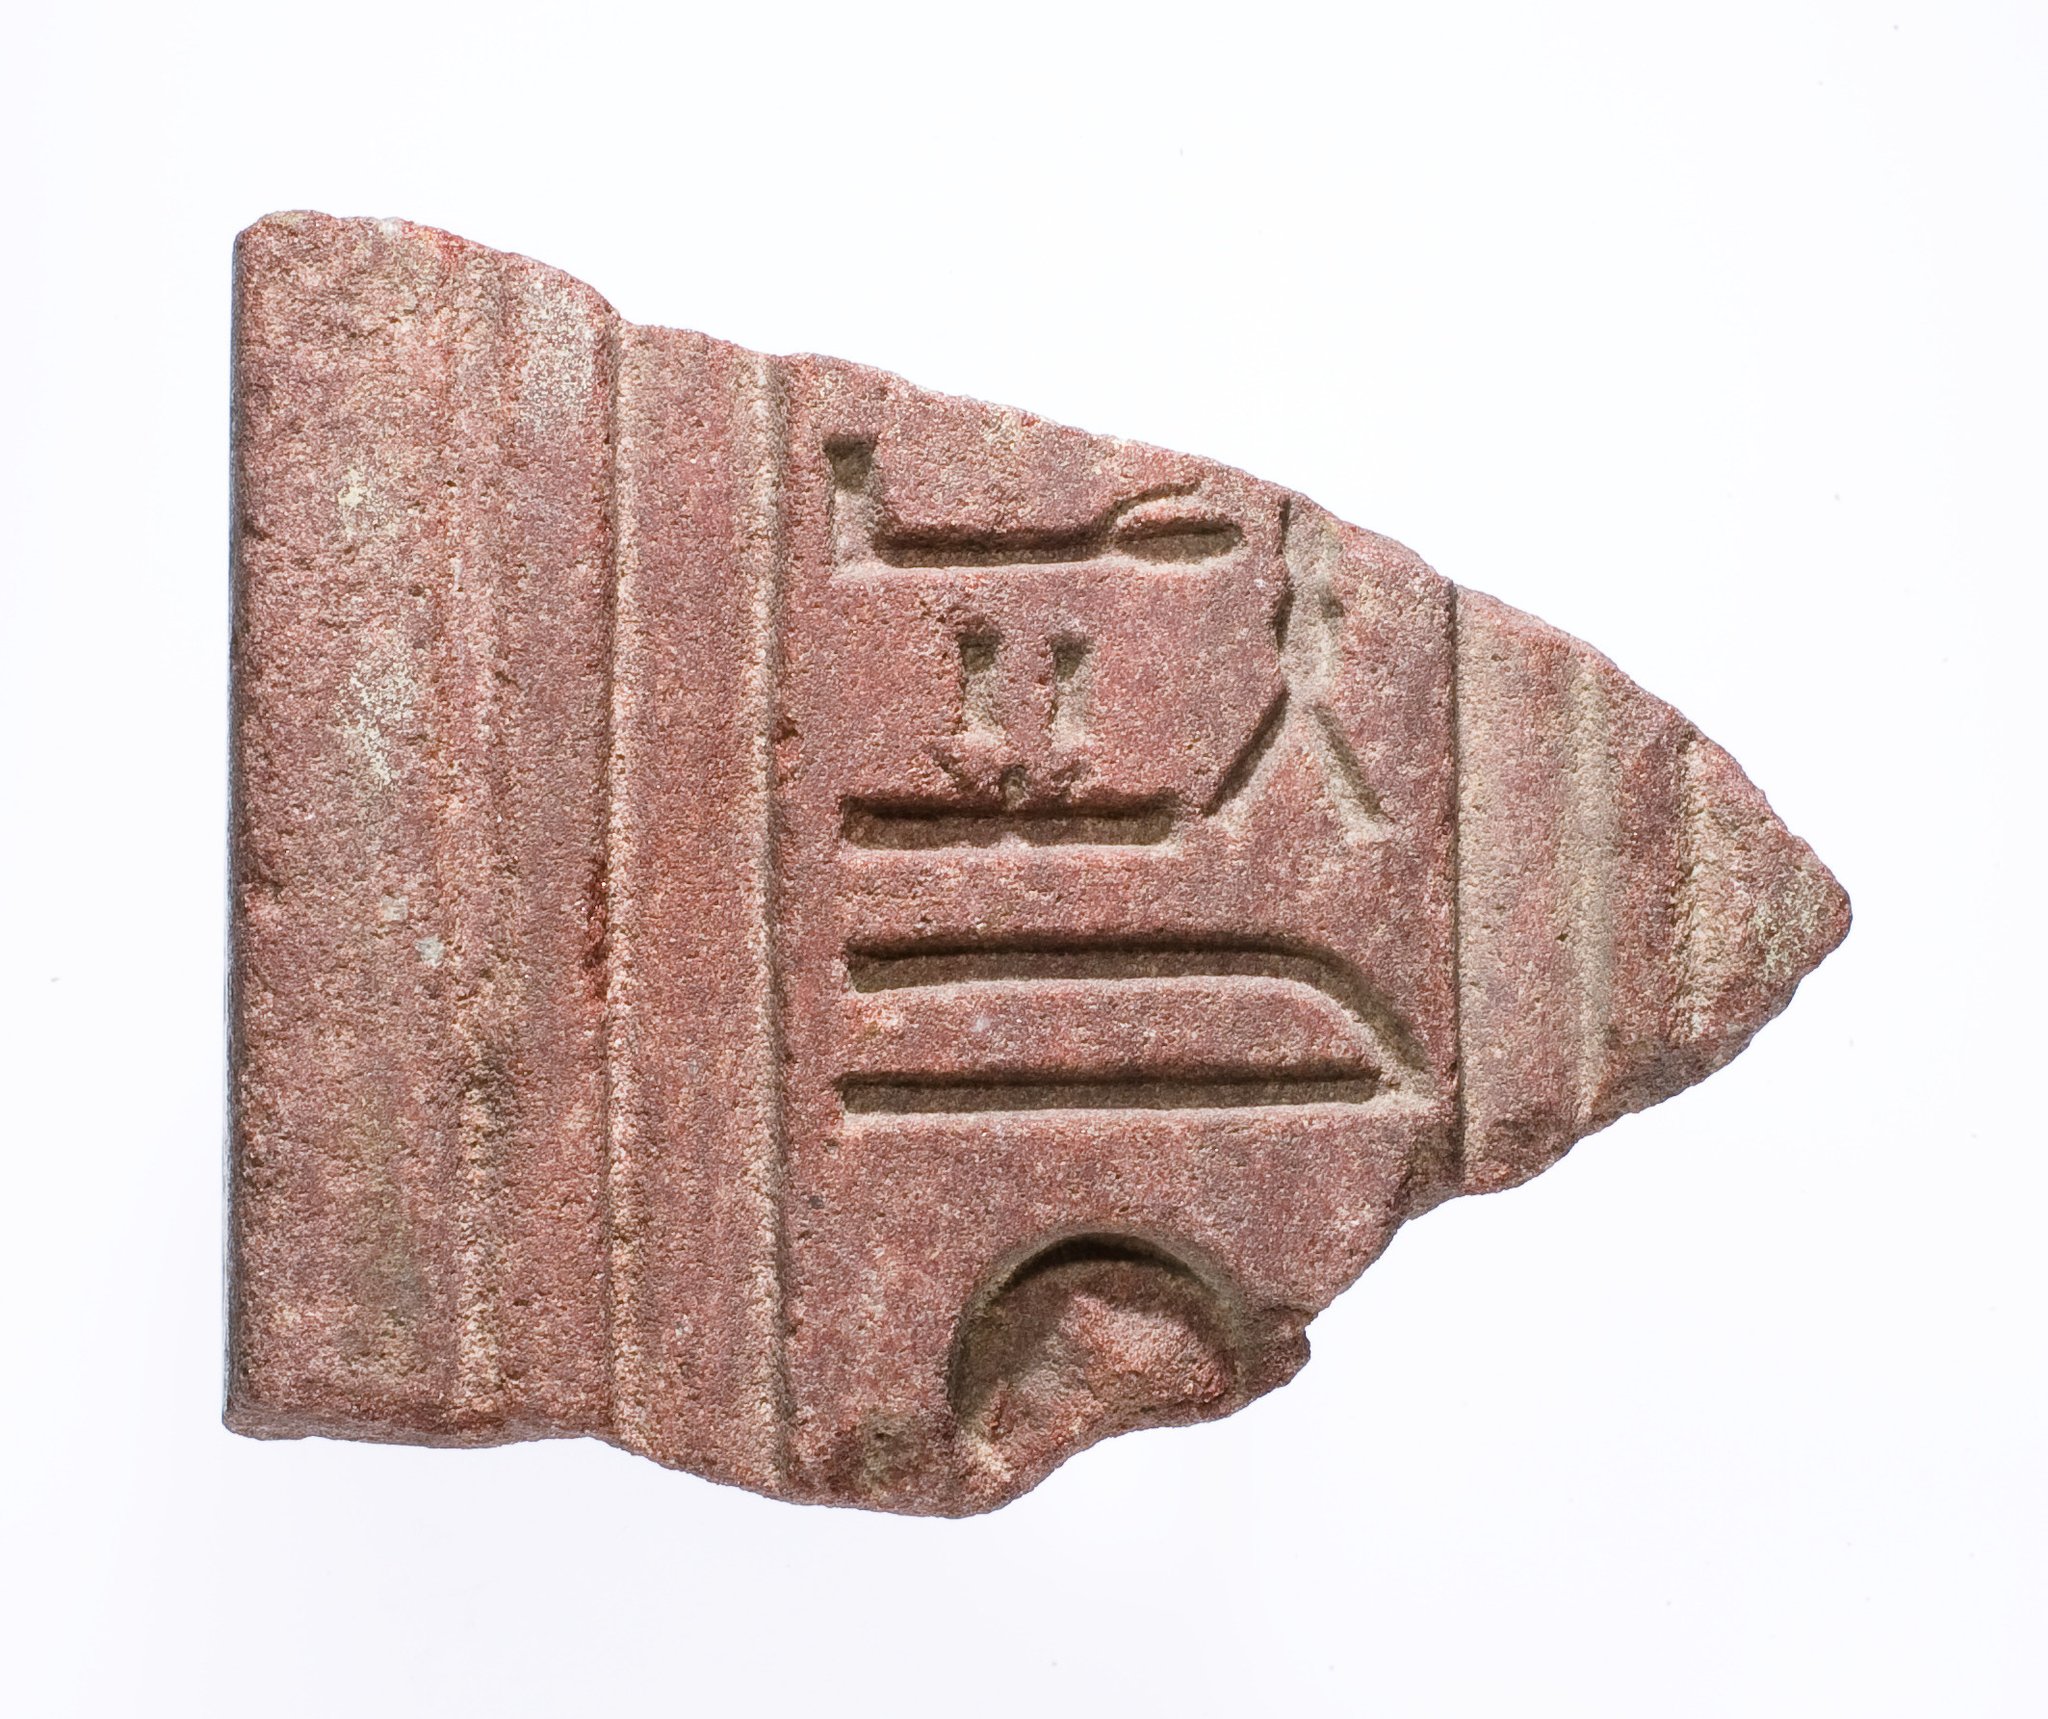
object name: back pillar or stela, first cartouche of the aten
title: Part of a (back?) pillar or stela with the first cartouche of the Aten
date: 1353-1336 BCE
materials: quartzite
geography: egypt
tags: cartouches